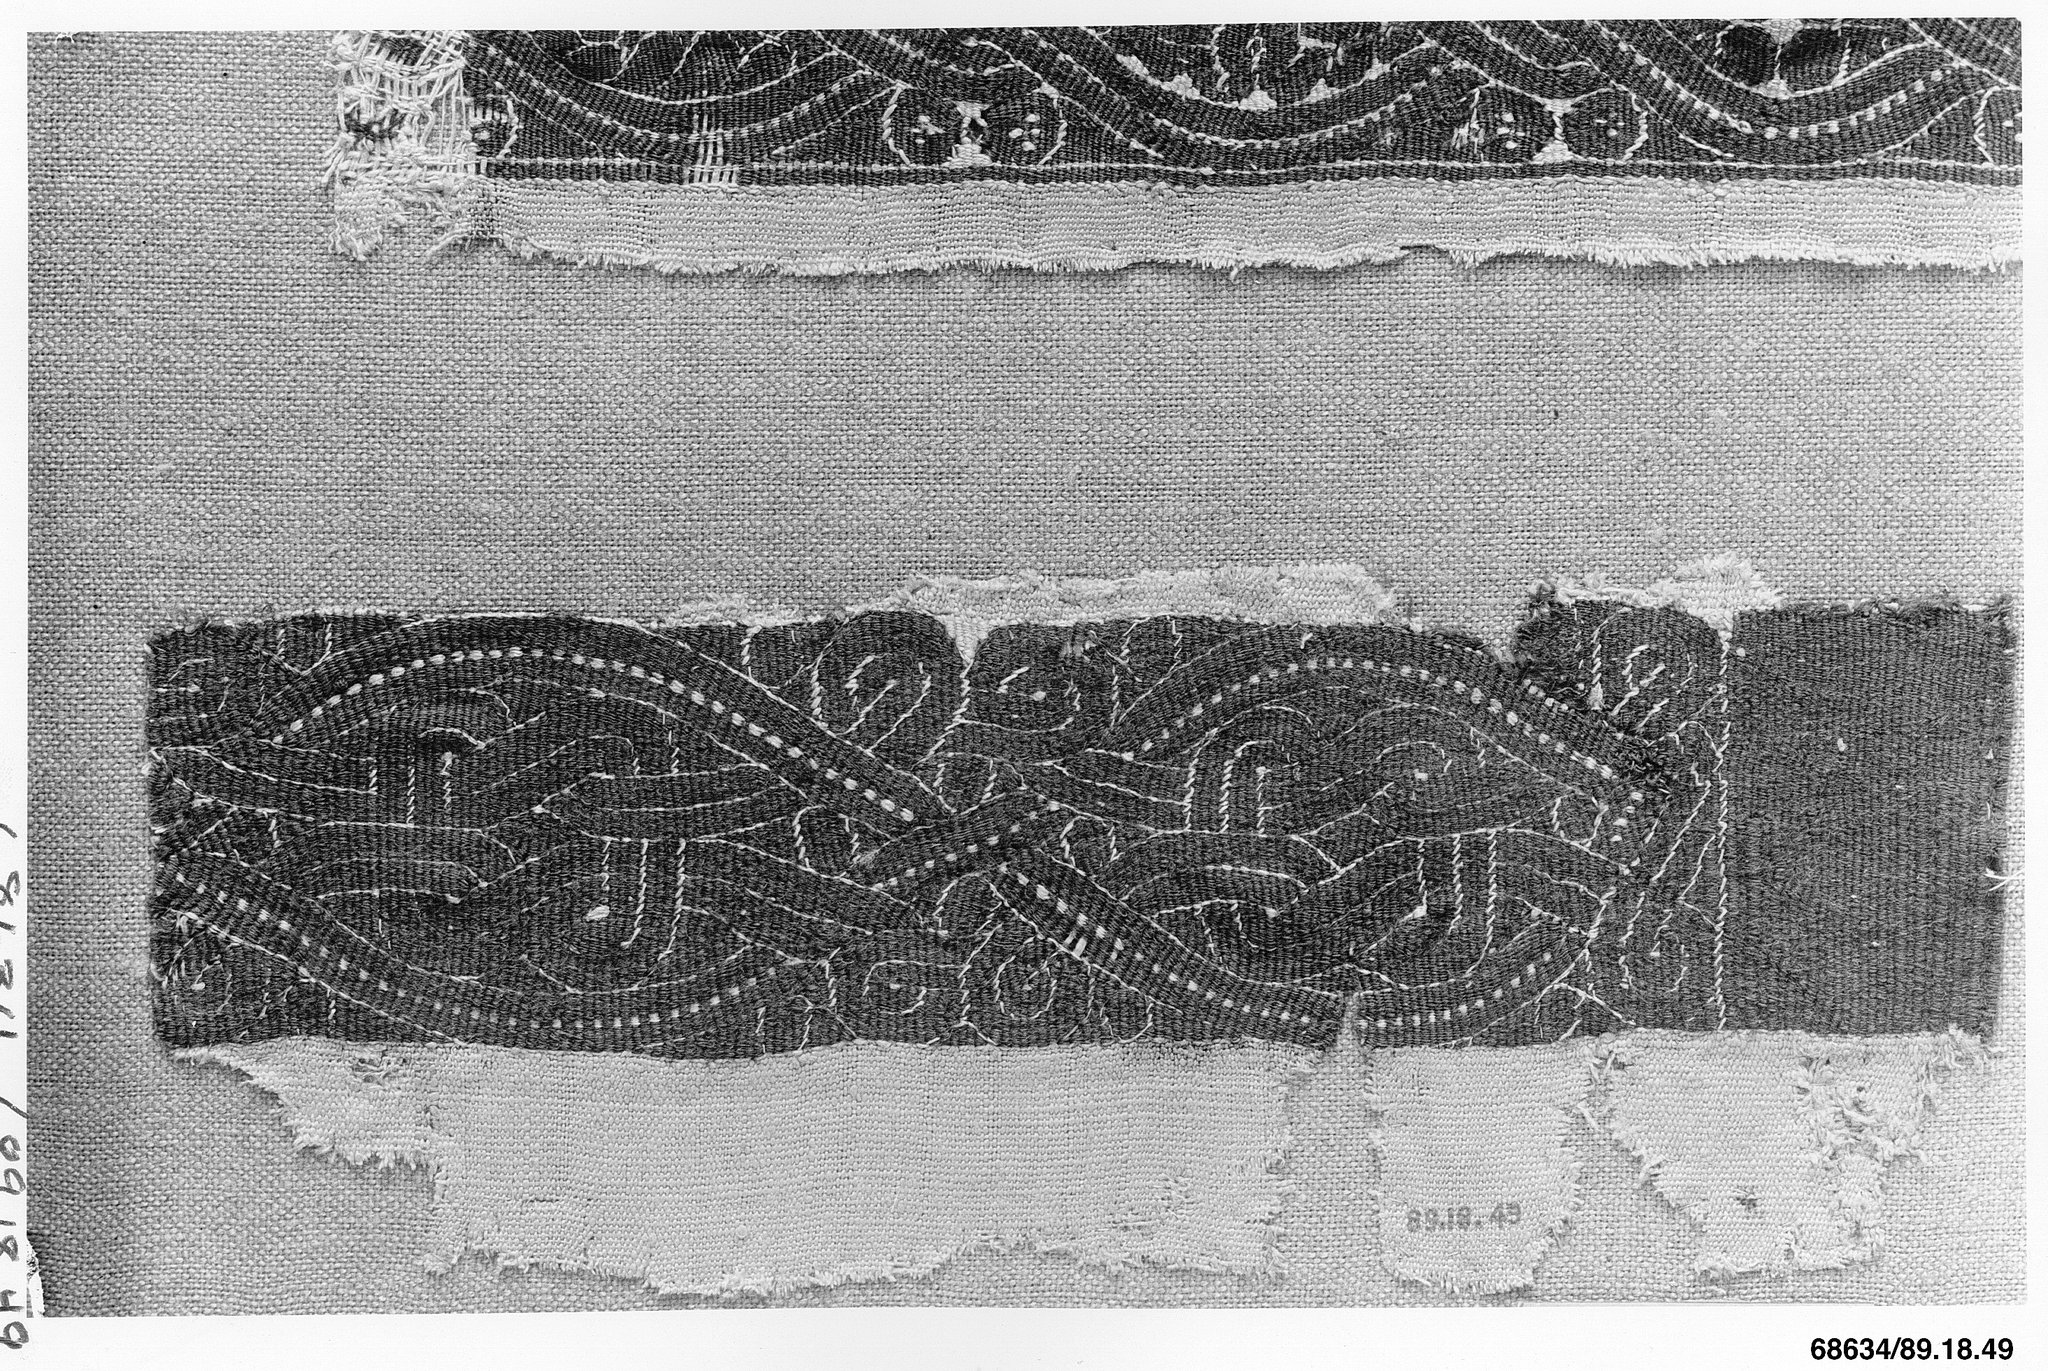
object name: textile fragment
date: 201-400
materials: linen, wool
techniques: weave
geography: egypt